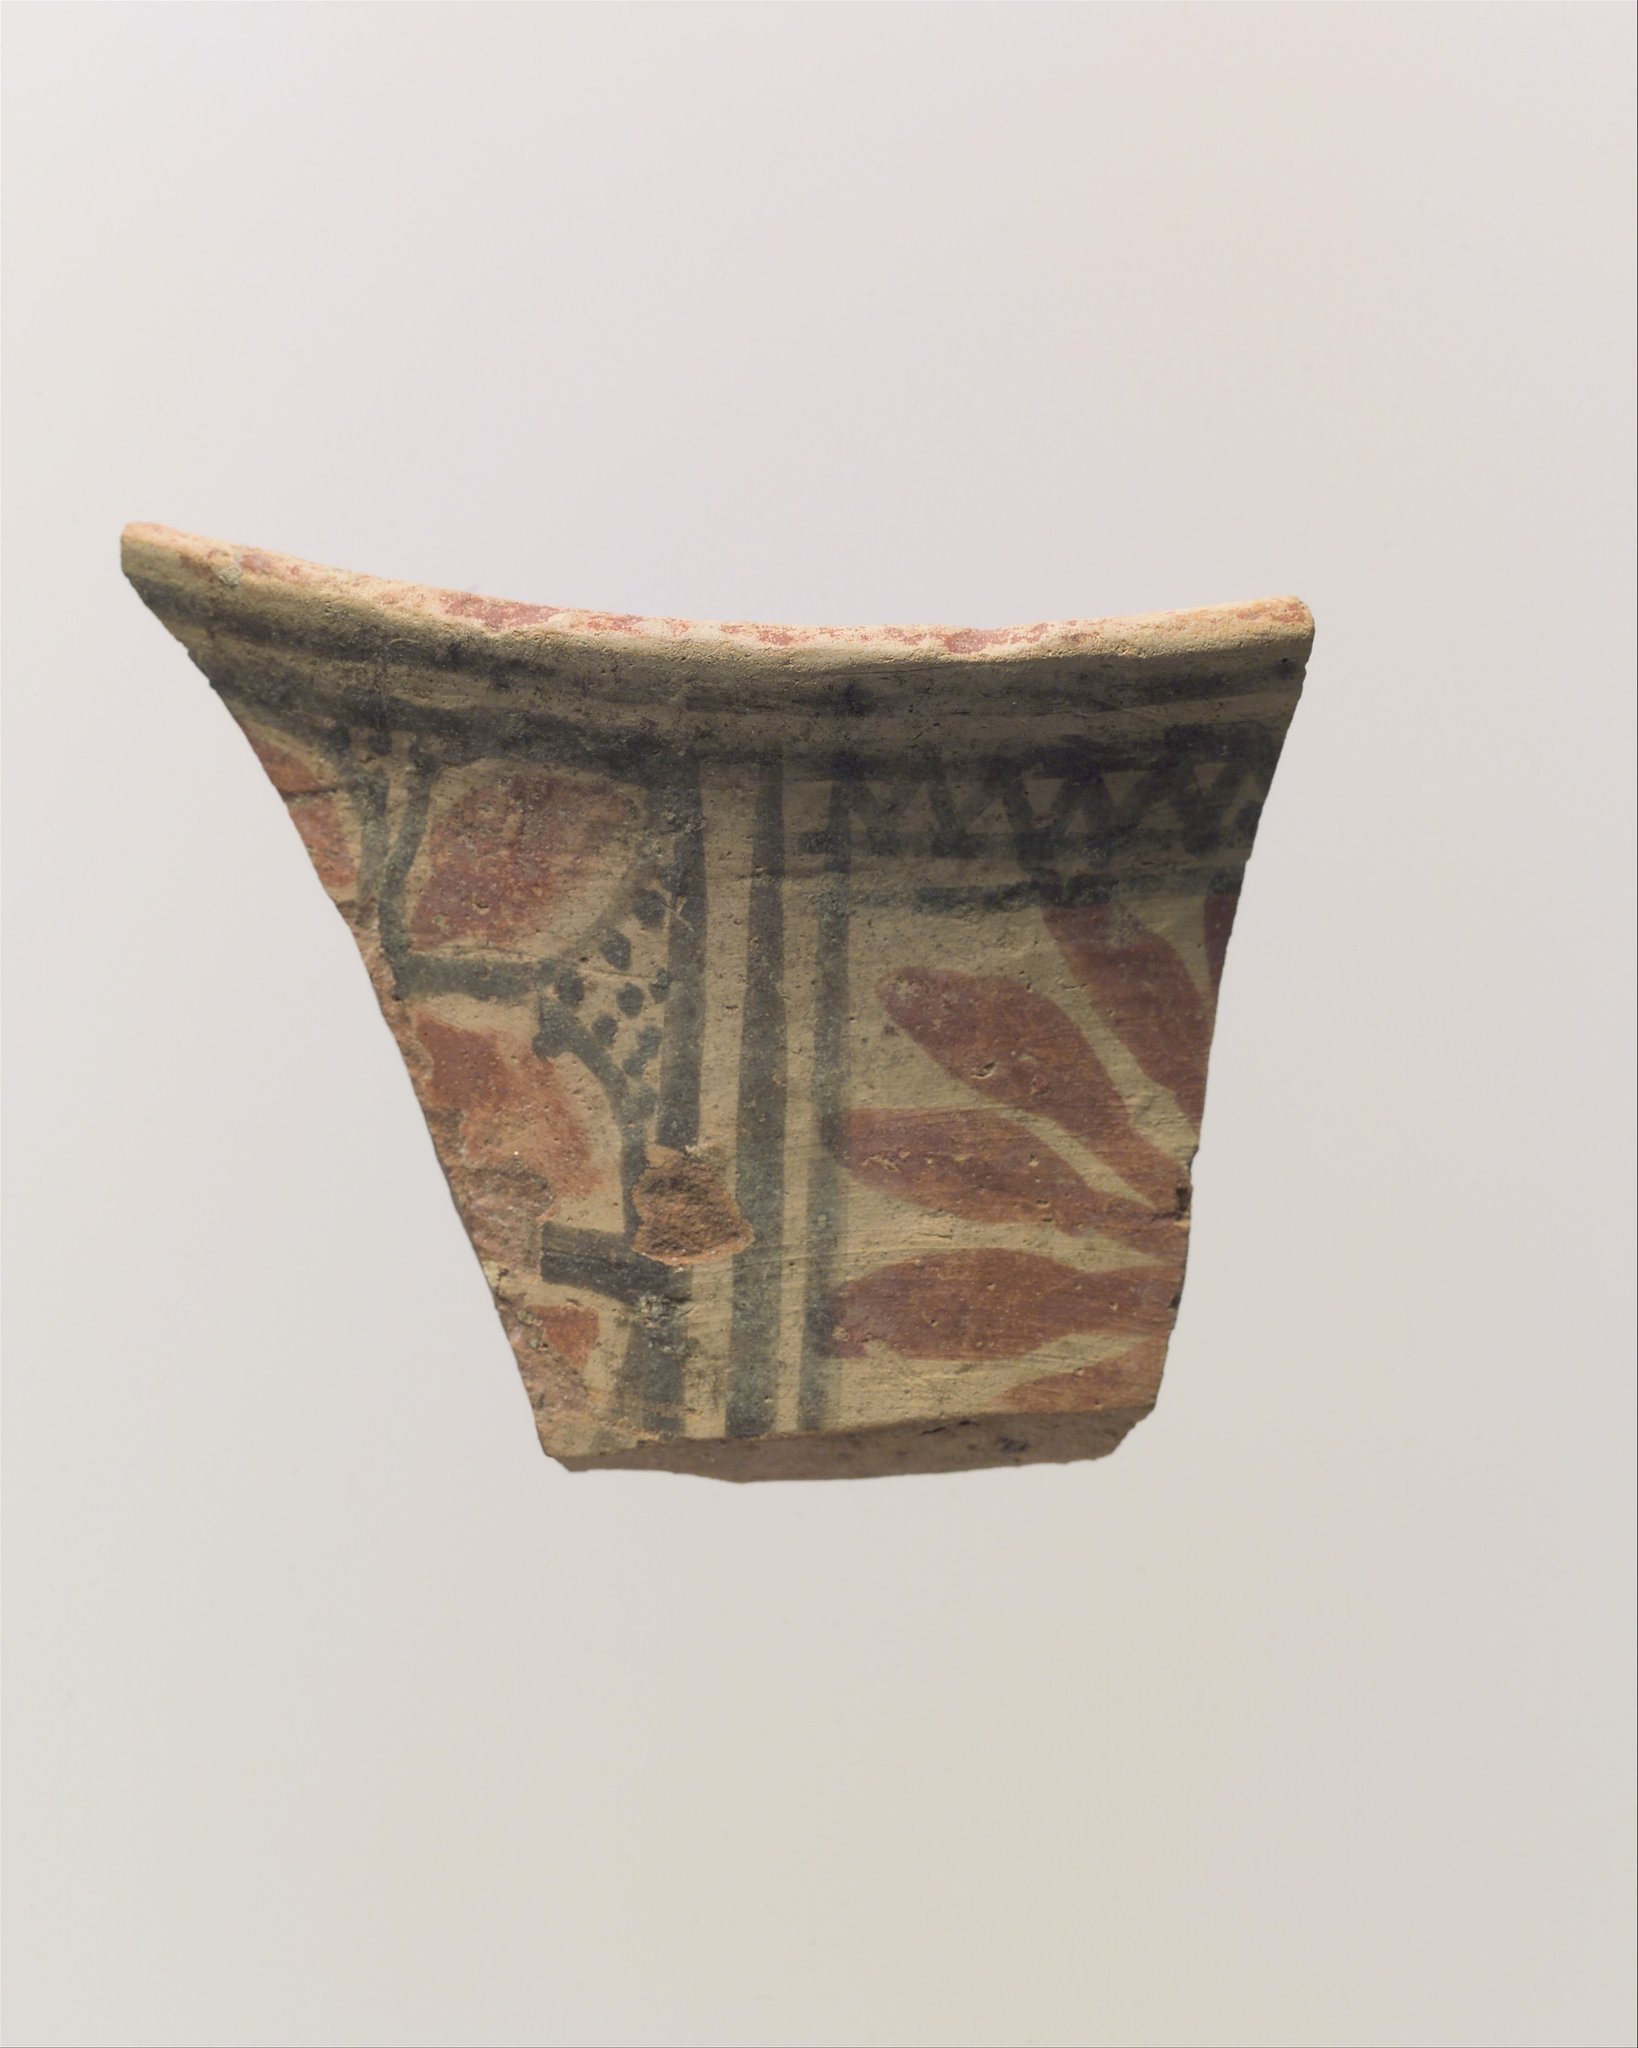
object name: sherd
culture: halaf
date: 5600-5000 BCE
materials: ceramic, paint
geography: syria